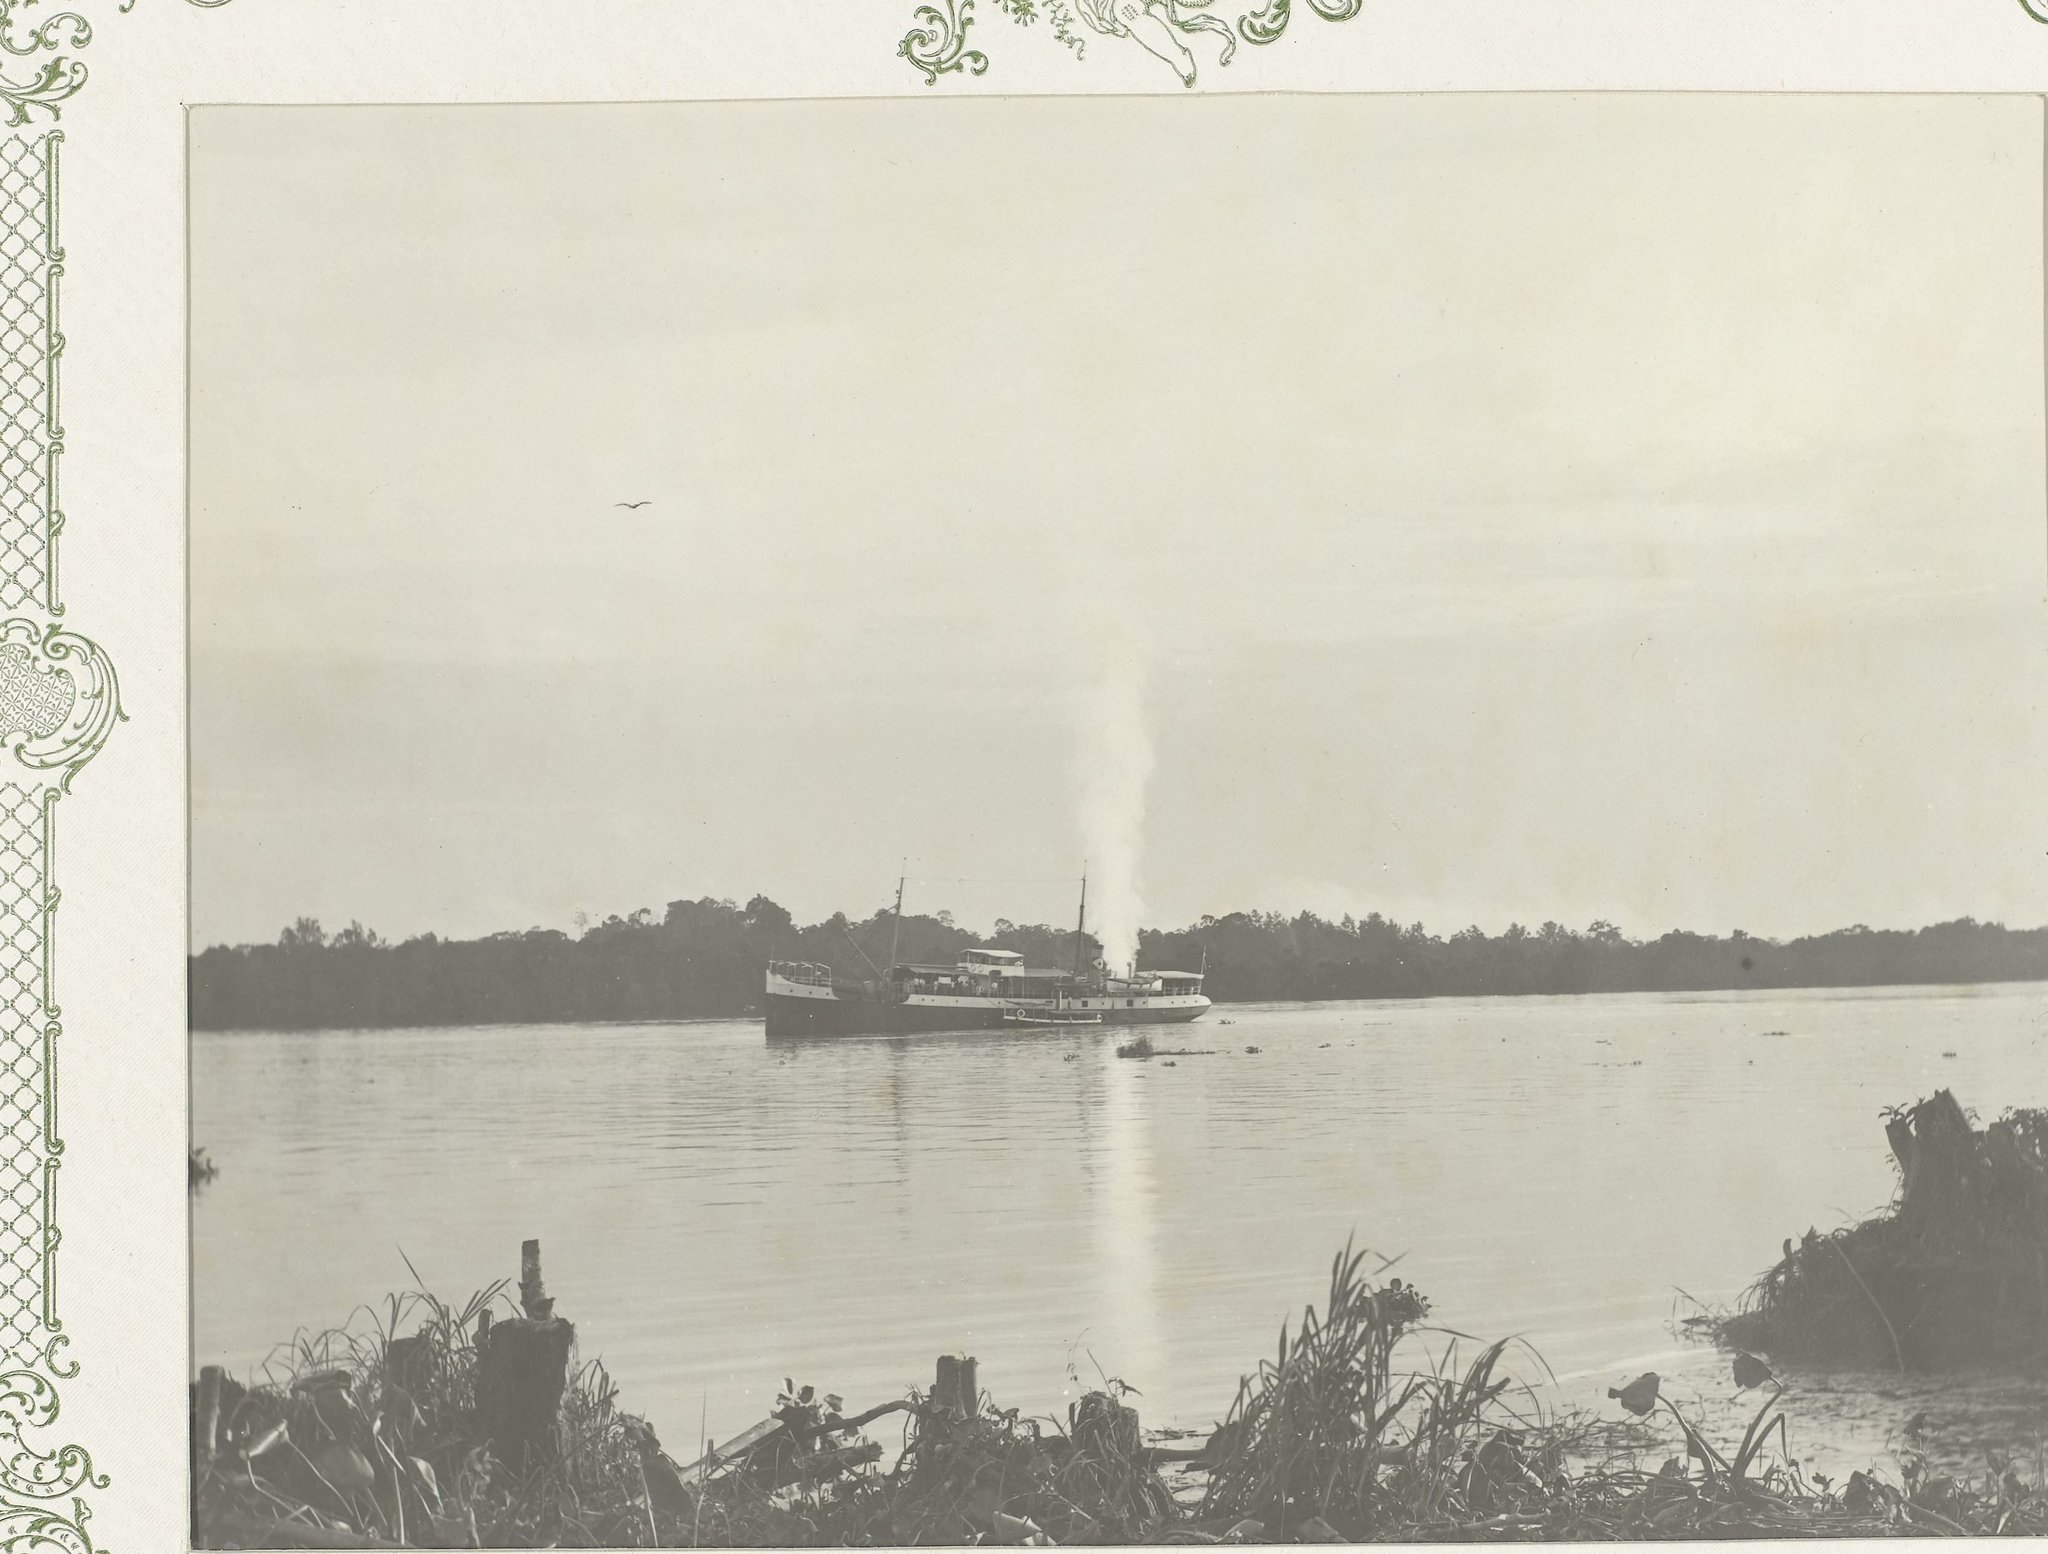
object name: photograph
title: Stoomschip op een rivier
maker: Anonymous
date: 1903-1907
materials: paper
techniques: gelatin silver print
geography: kalimantan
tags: river, steamship, motorship, borneo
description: Gezicht op een stoomschip varend op een rivier. Foto in het fotoalbum over de oliewinning op Borneo door de Koninklijke Nederlandsche Petroleum Maatschappij (KNPM) in de jaren 1903-1907.